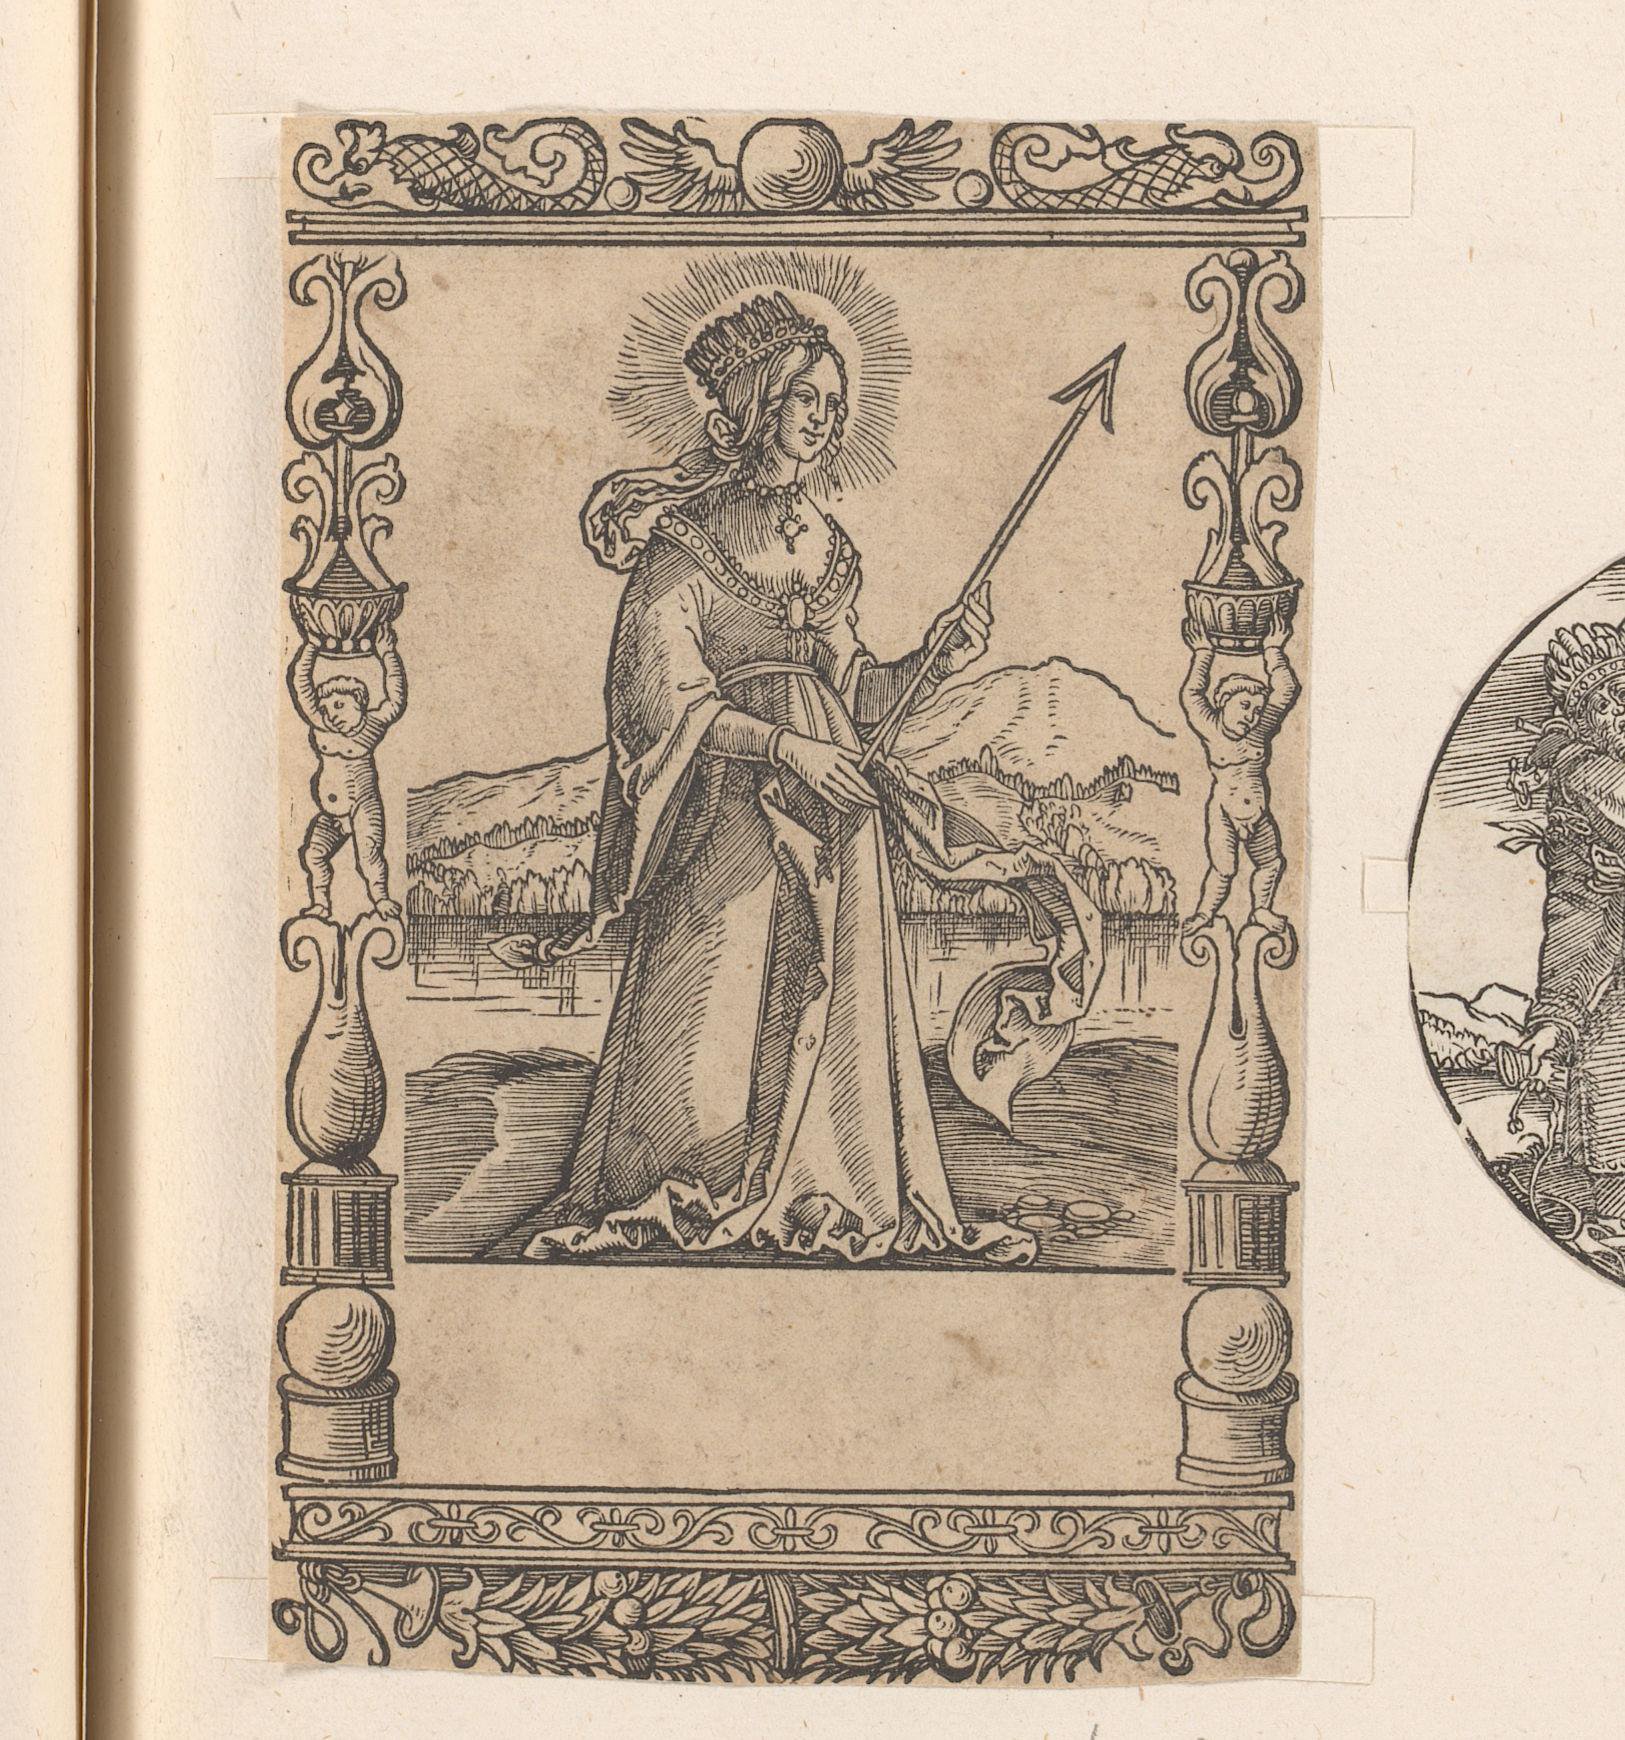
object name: book illustration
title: H. Ursula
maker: hans springinklee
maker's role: print maker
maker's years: -1540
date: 1516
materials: paper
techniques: woodcut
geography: nuremberg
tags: the virgin martyr ursula of cologne; possible attributes: arrow, banner with red cross, cloak of ermine, crown, ship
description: De Heilige Ursula met een pijl in haar hand. Op de achtergrond de rivier de Rijn. Rond de voorstelling een ornamentele rand. Prent maakt deel uit van een album.